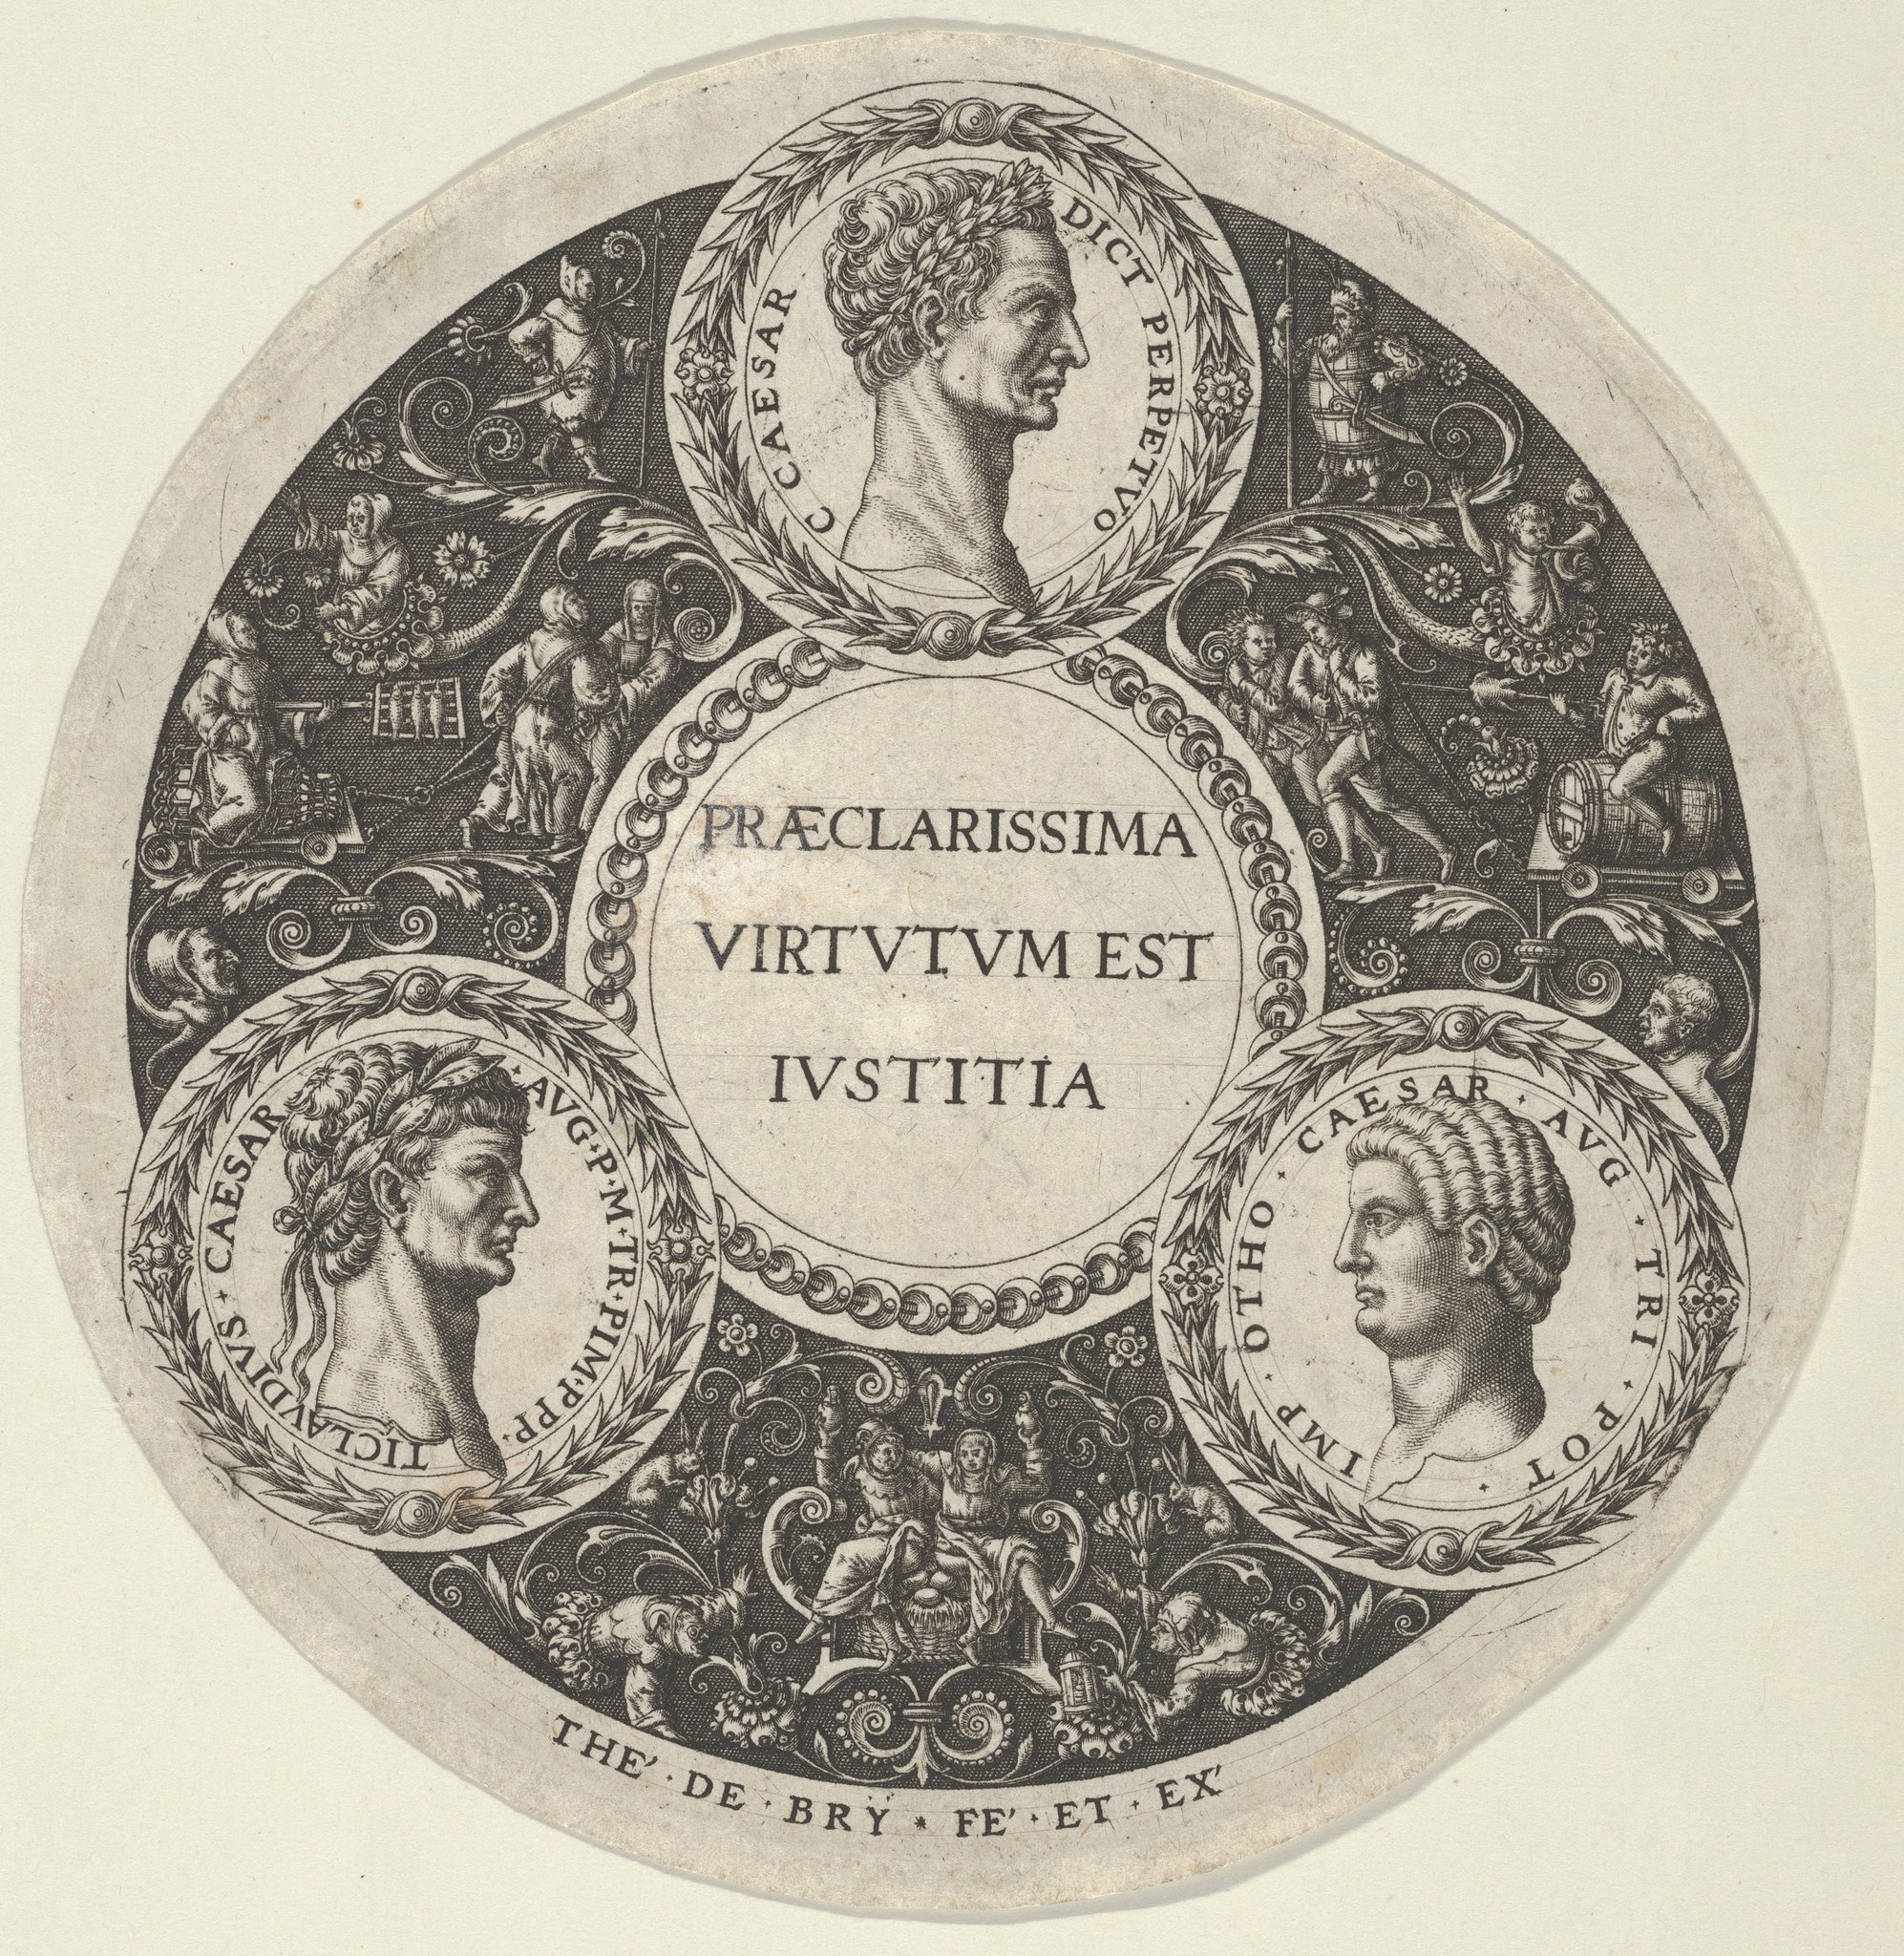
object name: print ornament architecture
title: Design for a Dish with Portraits of the Roman Emperors Caesar, Claudius, and Otho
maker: theodor de bry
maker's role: artist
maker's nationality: netherlandish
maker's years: 1528-1598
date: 1588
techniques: engraving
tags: julius caesar,men,dishes